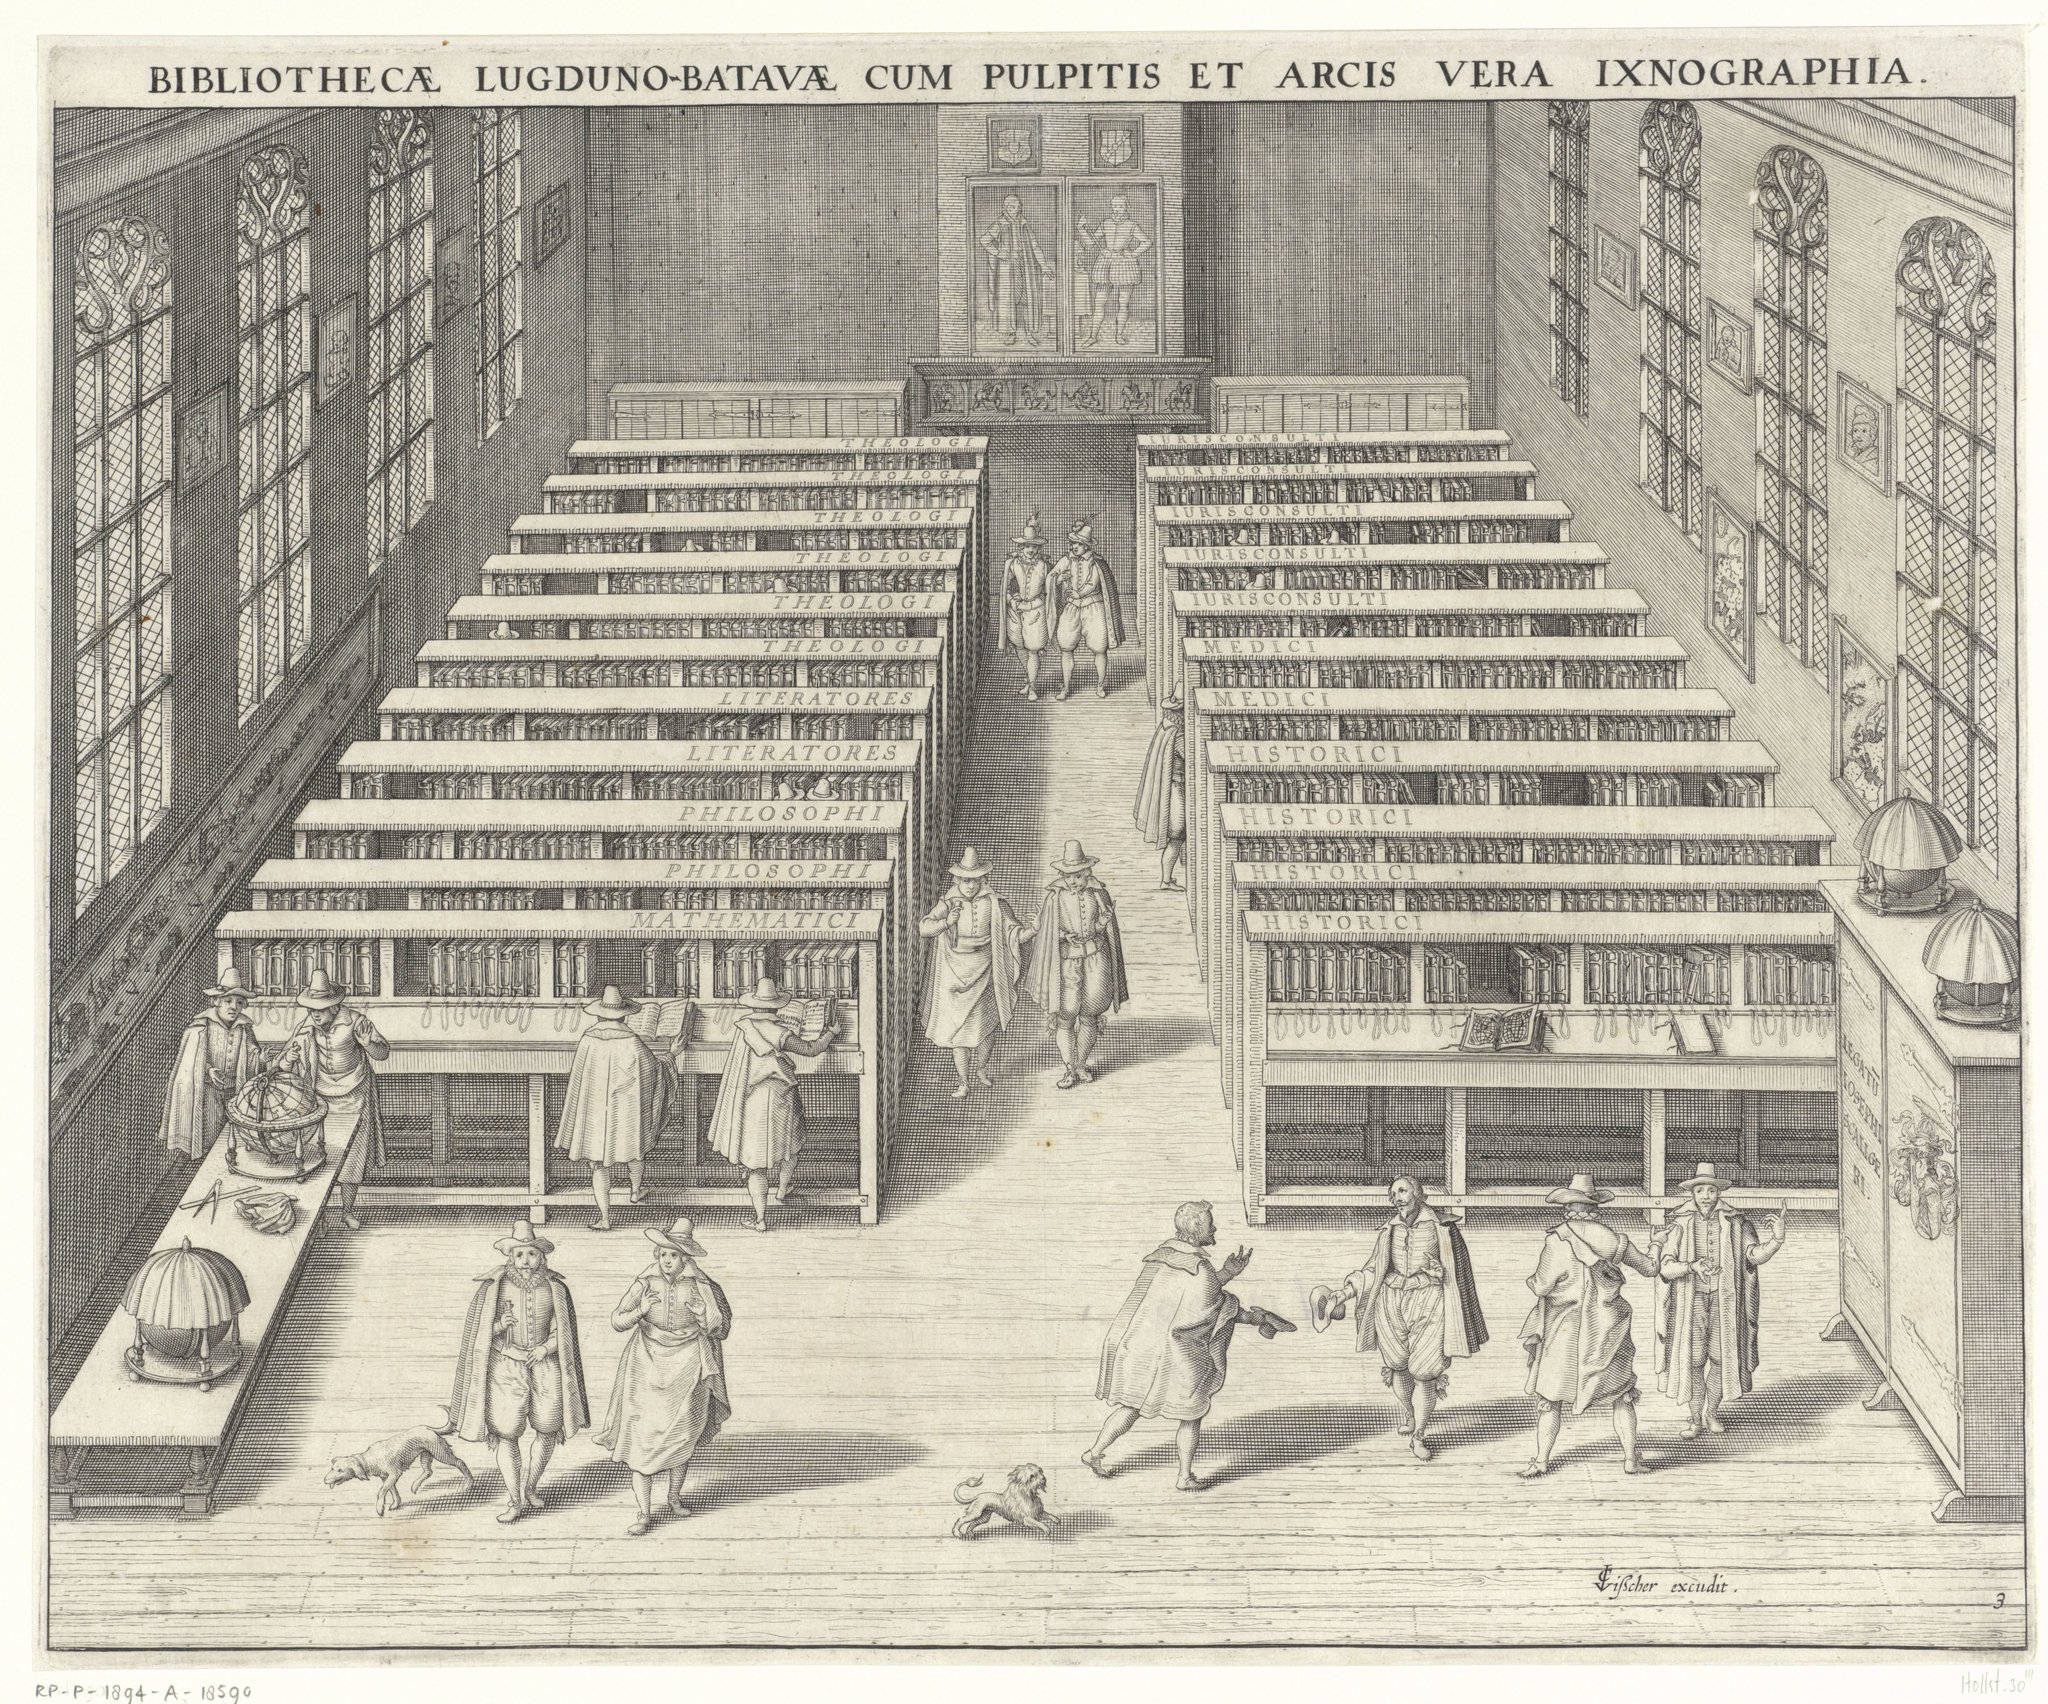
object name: print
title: Bibliothecae Lugduno-Batavae cum pulpitis et arcis vera ixnographia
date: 1610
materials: paper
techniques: engraving, etching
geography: northern netherlands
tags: university, public library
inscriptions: collector's mark: Lugt 2228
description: Bibliotheek van de Universiteit van Leiden. Interieur met de kasten met de boeken aan kettingen. Op de voorgrond en tussen de kasten verschillende bezoekers. Links een tafel met globes. Rechts een kast gemerkt: Legatu[] Josephi Scaligeri. Aan de wanden kaarten, prenten en portretten. Onderdeel van een groep van vier gezichten van de Universiteit van Leiden, later gebruikt als illustratie in het supplement van het boek van Meursius over de Leidse universiteit.